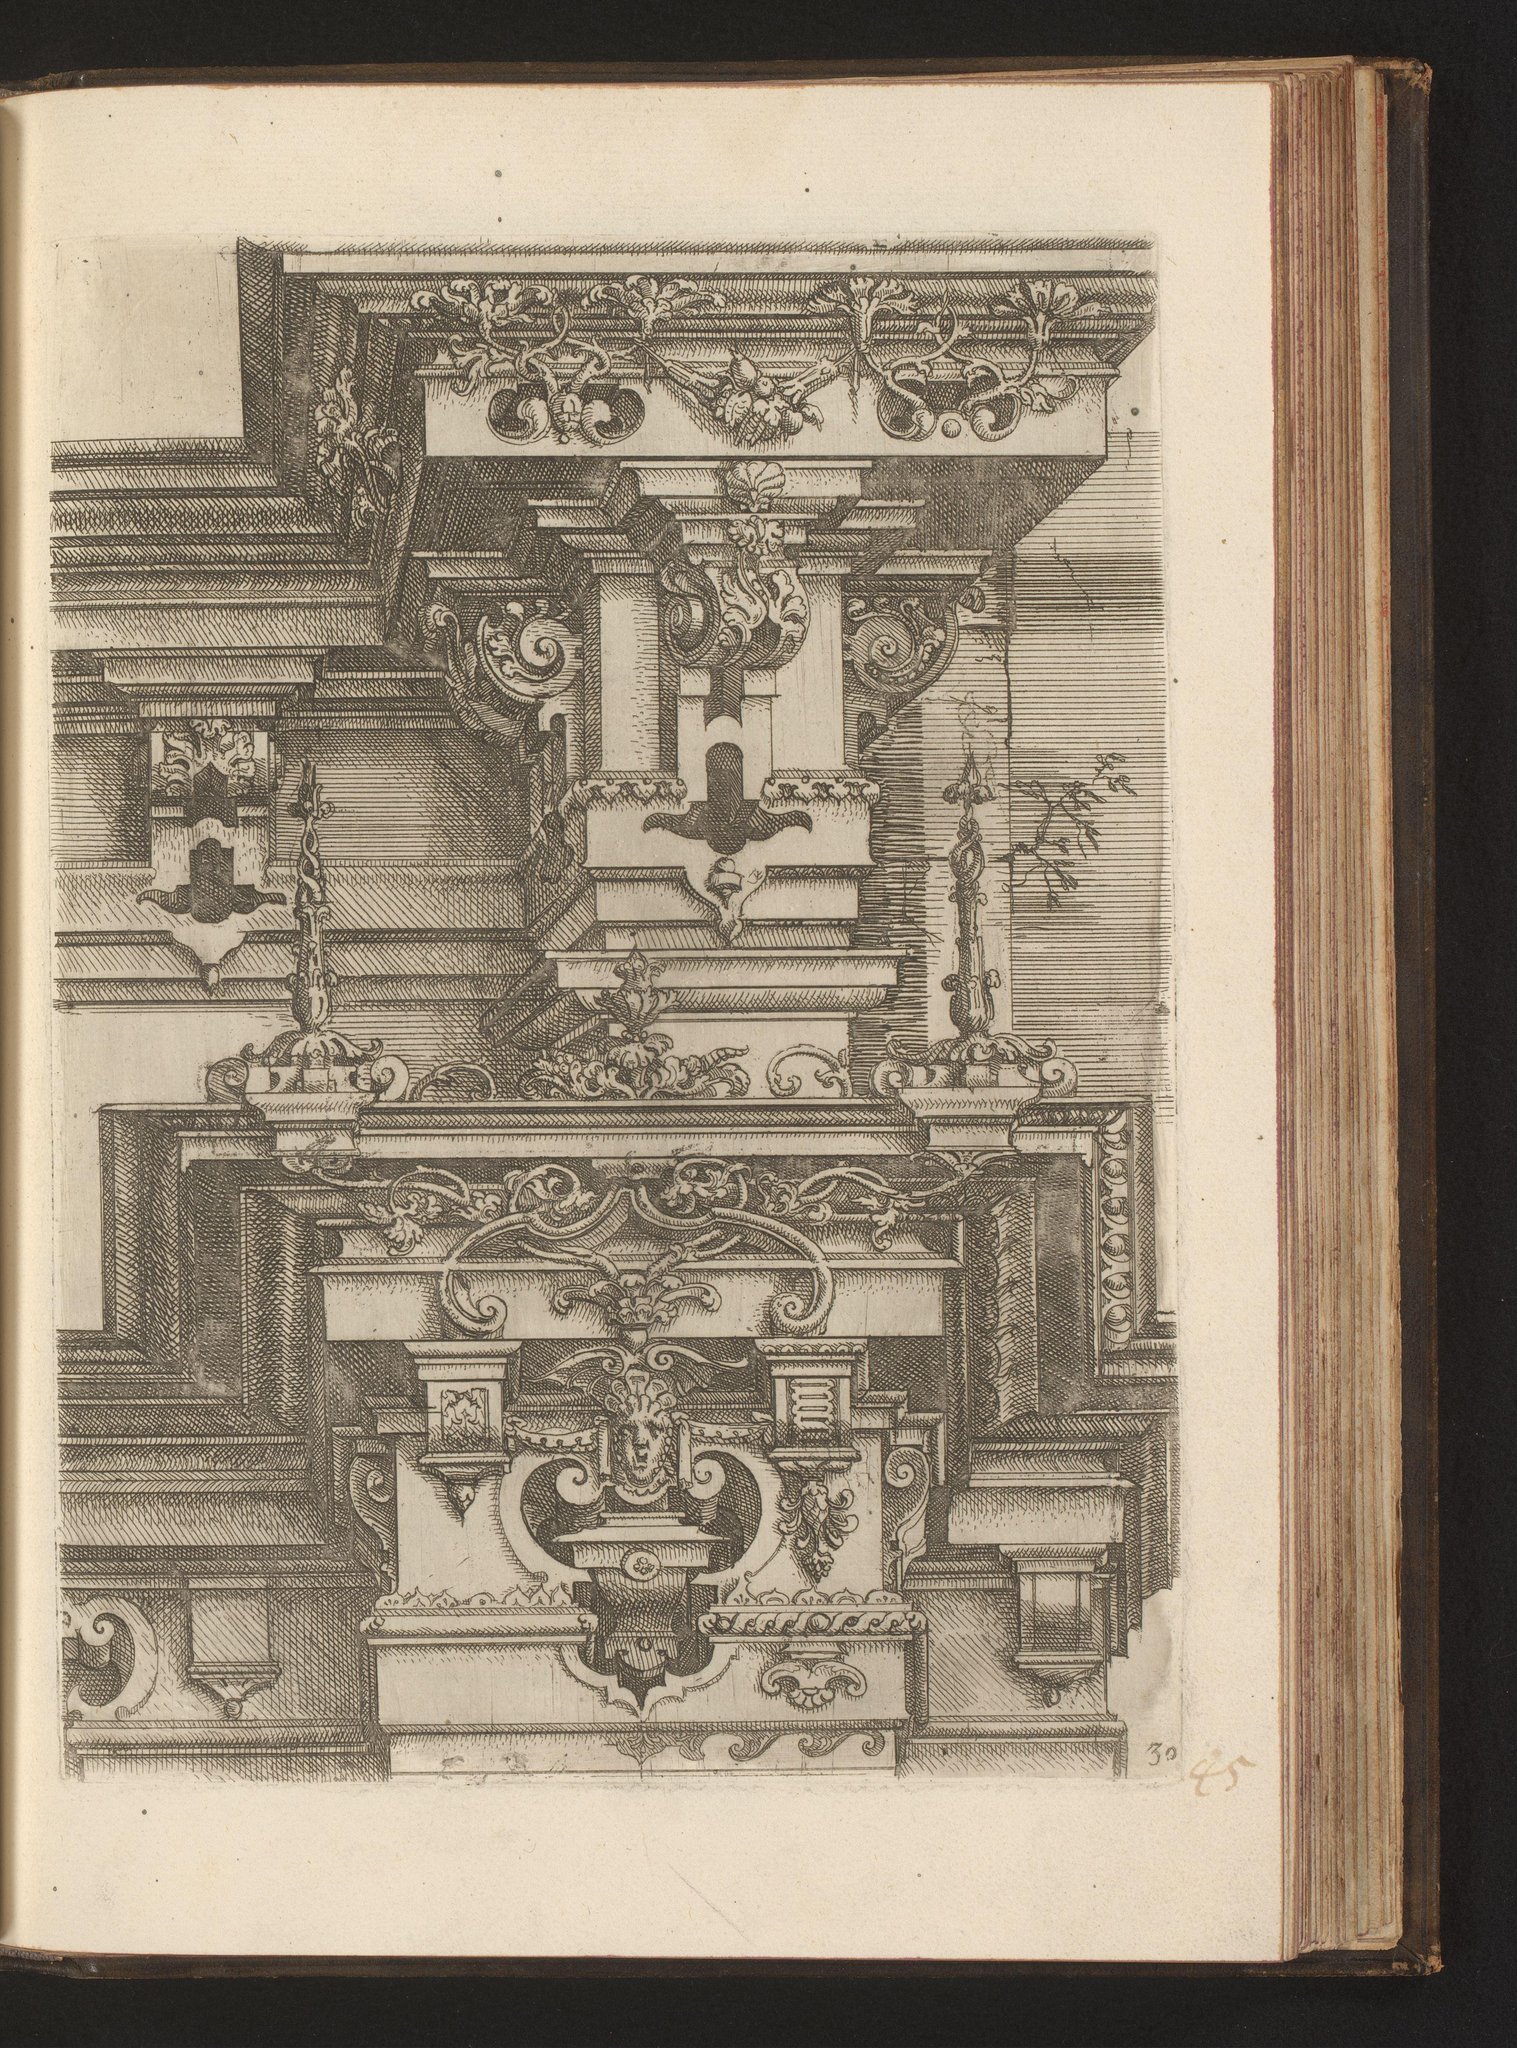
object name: book illustration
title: Architectura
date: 1593-1595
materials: paper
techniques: etching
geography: straatsburg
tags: composite order ~ architecture, column, pillar ~ architecture, other architectural details (entablature), other architectural details, ornament ~ festoon, garland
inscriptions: collector's mark: Lugt 2760, collector's mark: Lugt 2228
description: Prent gebruikt in: Dietterlin, Wendel (I). Architectura de quinq[ue] columnarum simmetrica distributione et variis eorundem or namentis: Liber I. Straatsburg: Bernhard Jobin, 1593.